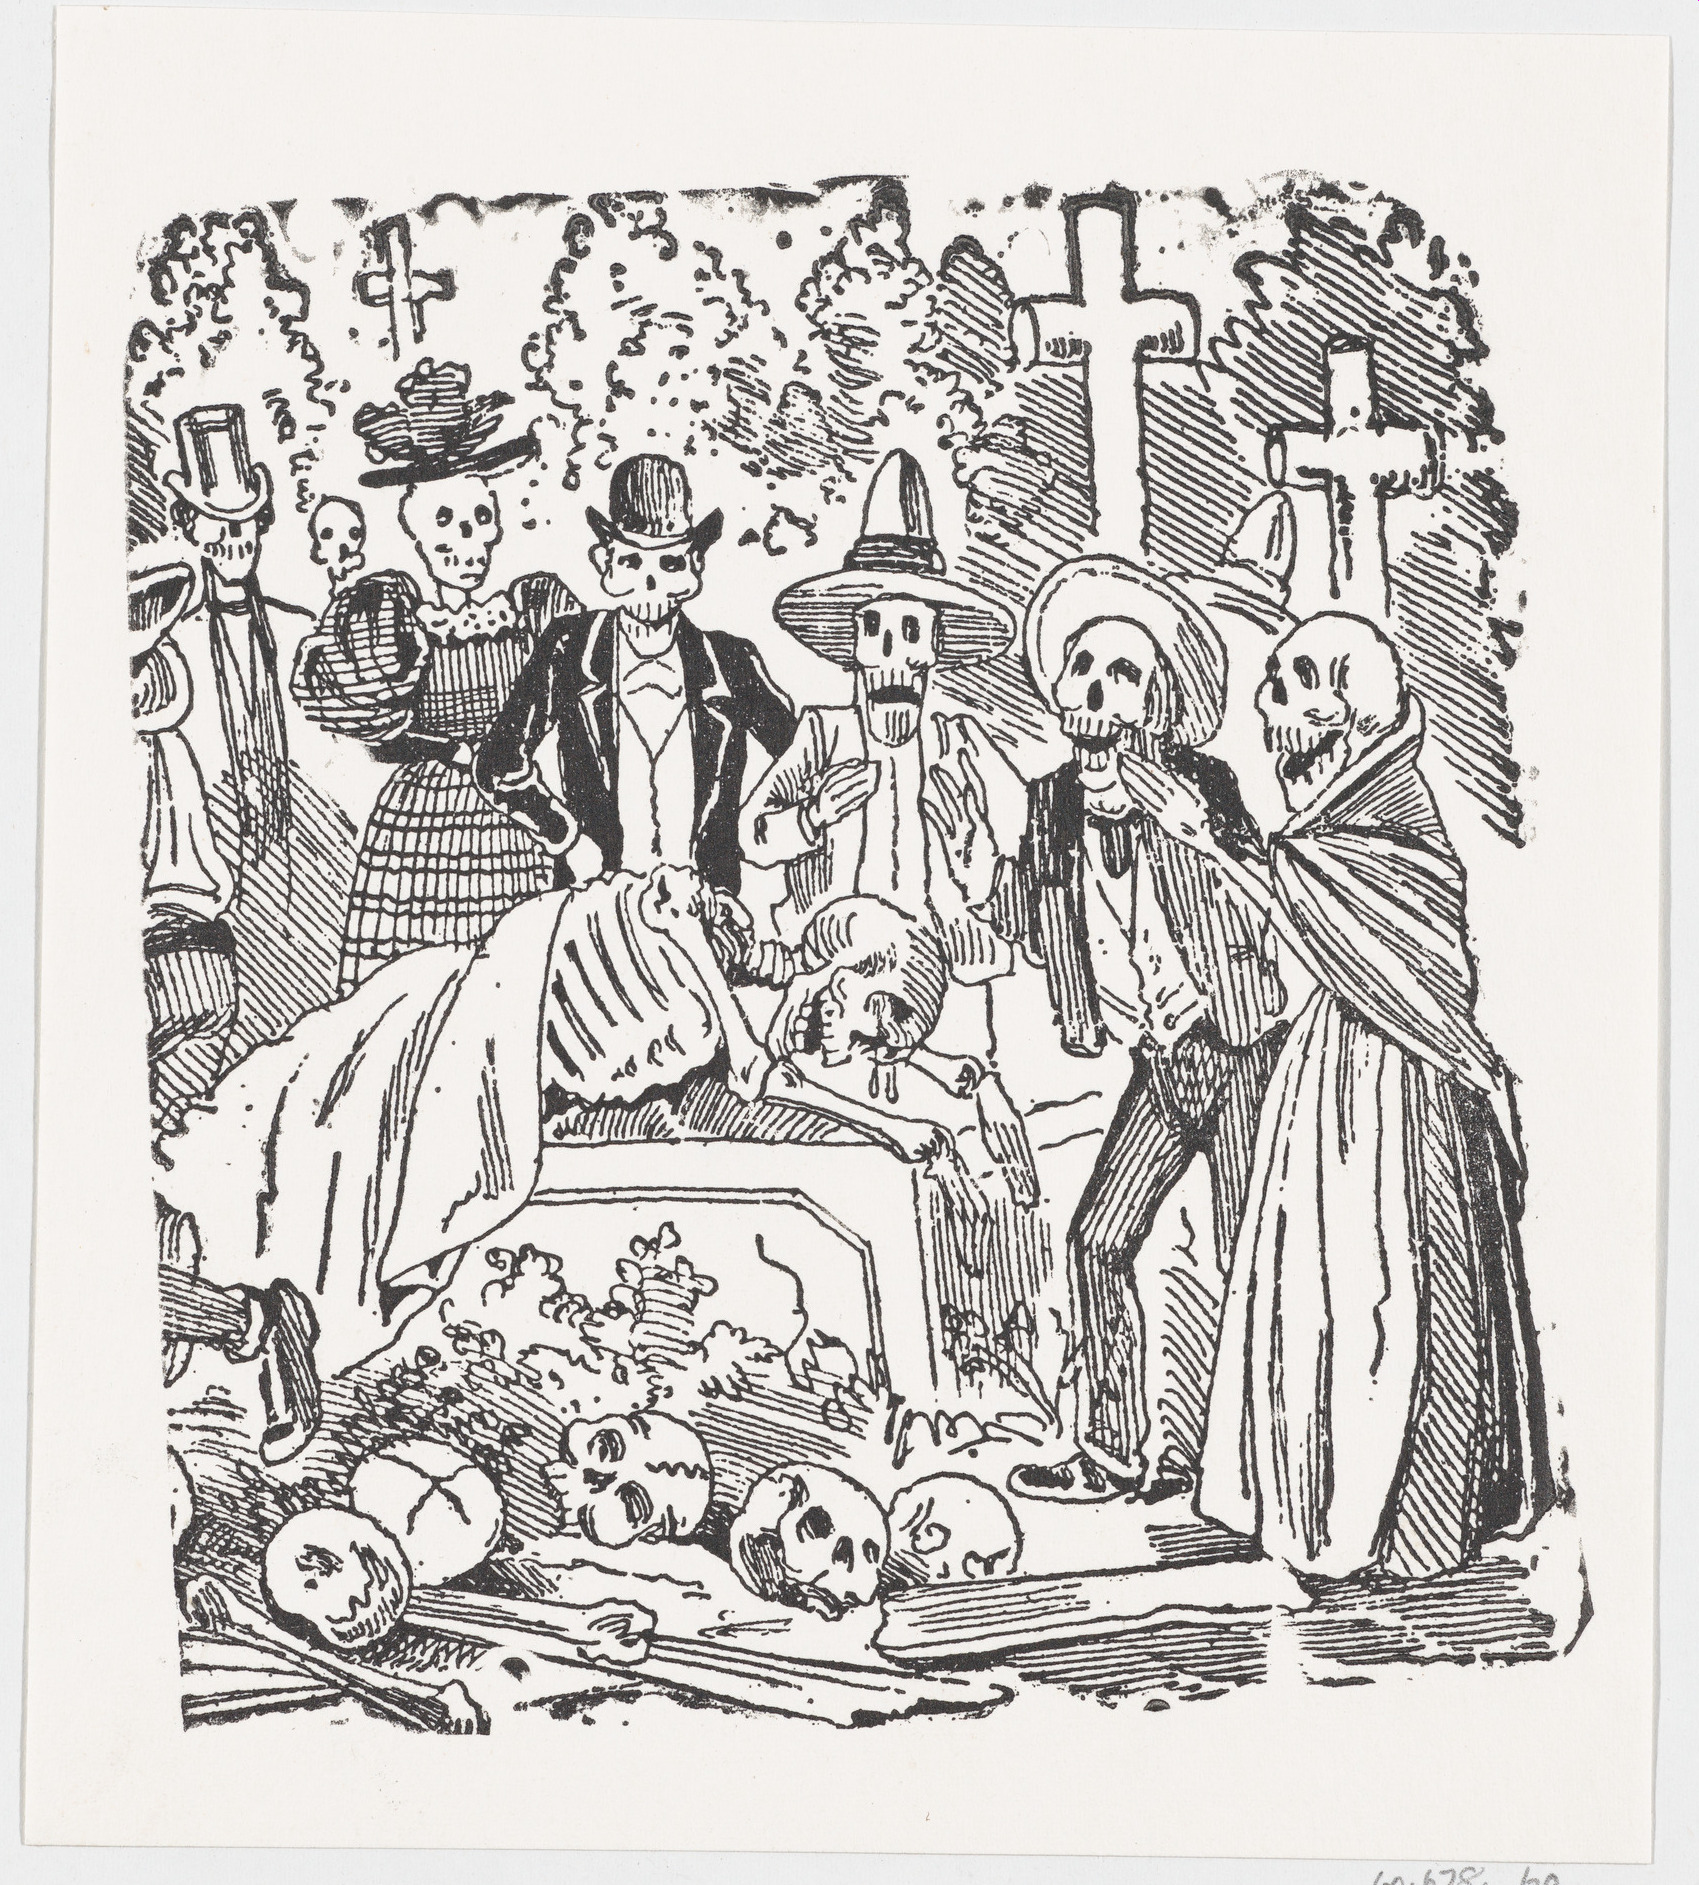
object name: print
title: A skeleton covered with a sheet crying in a cemetery, from a broadside entitled ' Calavera llorando el hueso'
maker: josé guadalupe posada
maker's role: artist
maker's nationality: mexican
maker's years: 1852-1913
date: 1880-1910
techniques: lithography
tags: skeletons,skulls,cross,burials